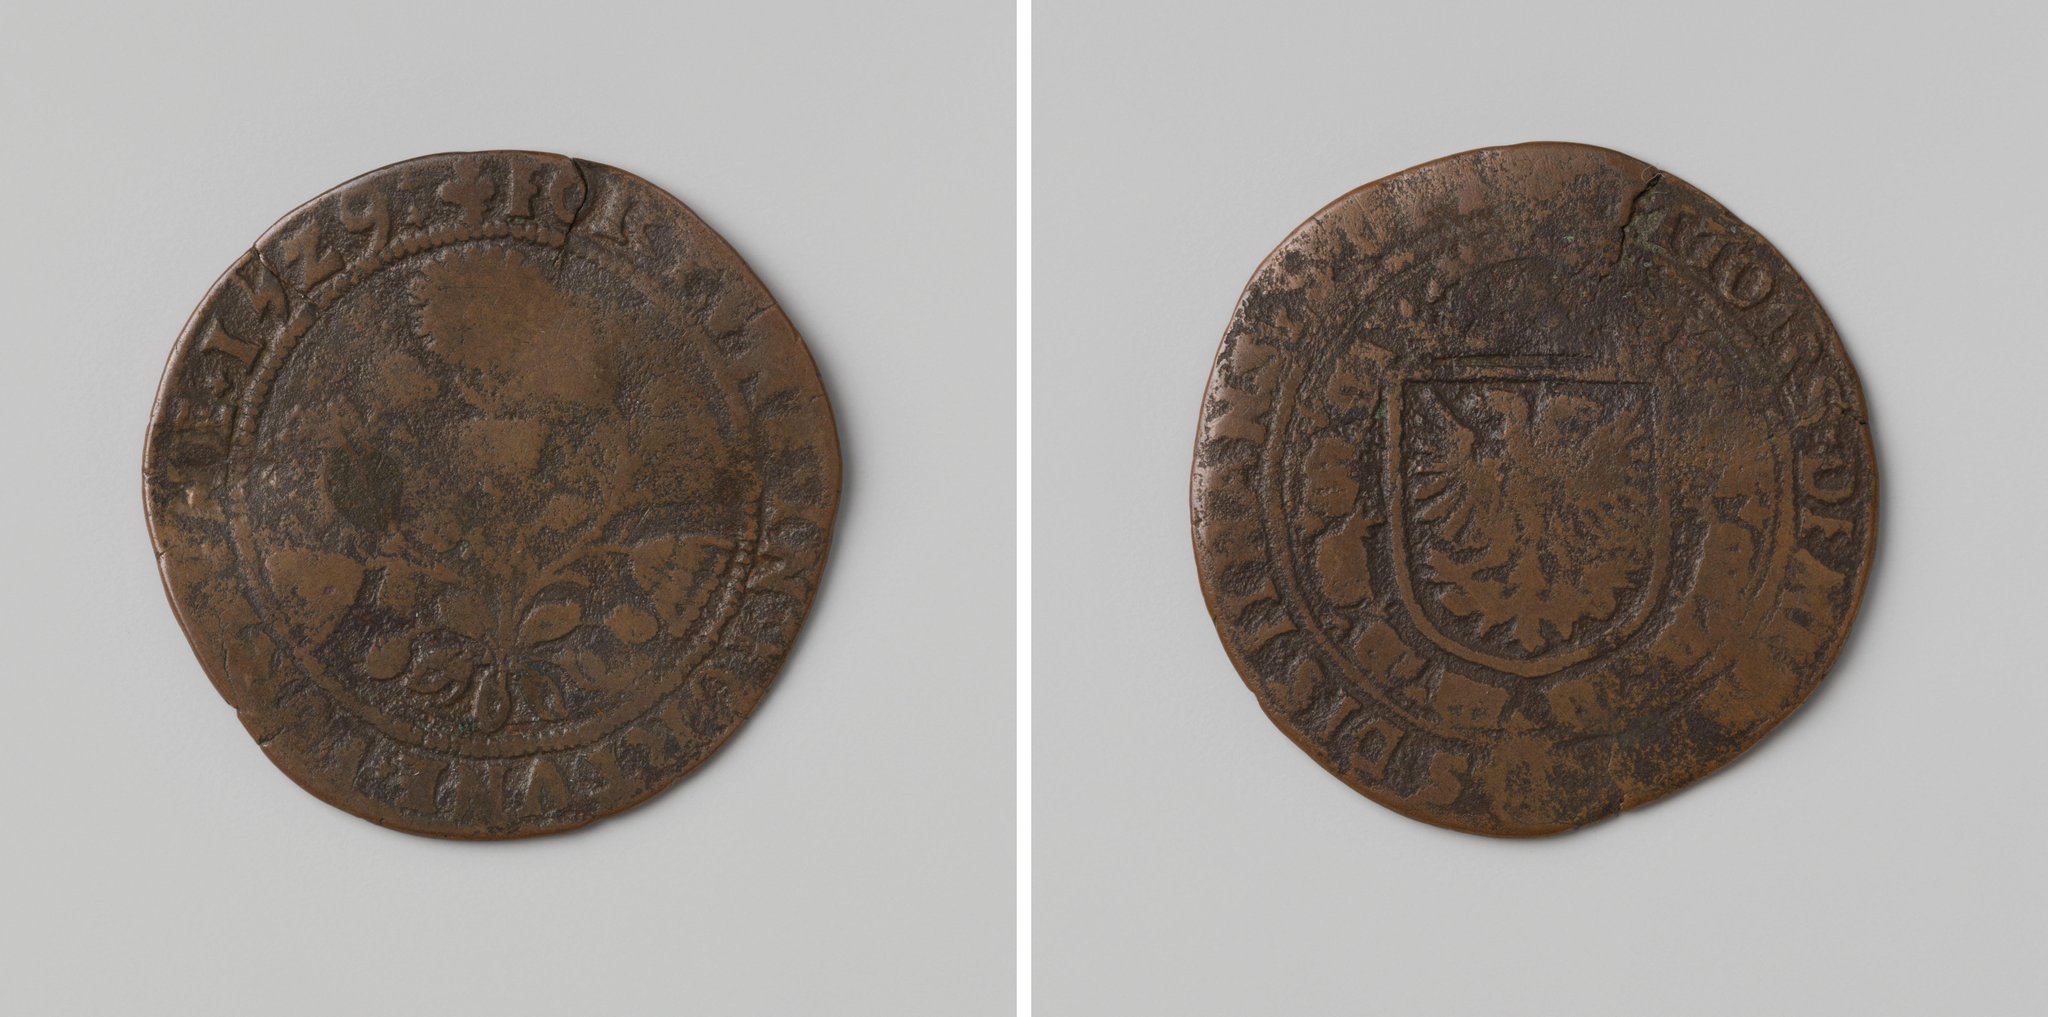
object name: jeton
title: Margarteha van Oostenrijk, landvoogdes der Nederlanden, rekenpenning van de raad van Financiën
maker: Anonymous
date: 1529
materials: copper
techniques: striking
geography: netherlands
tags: brussels, mechelen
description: Koperen penning. Voorzijde: bloeiende margrieten binnen omschrift. Keerzijde: gekroond wapenschild, omhangen met orde van Gulden Vlies binnen omschrift